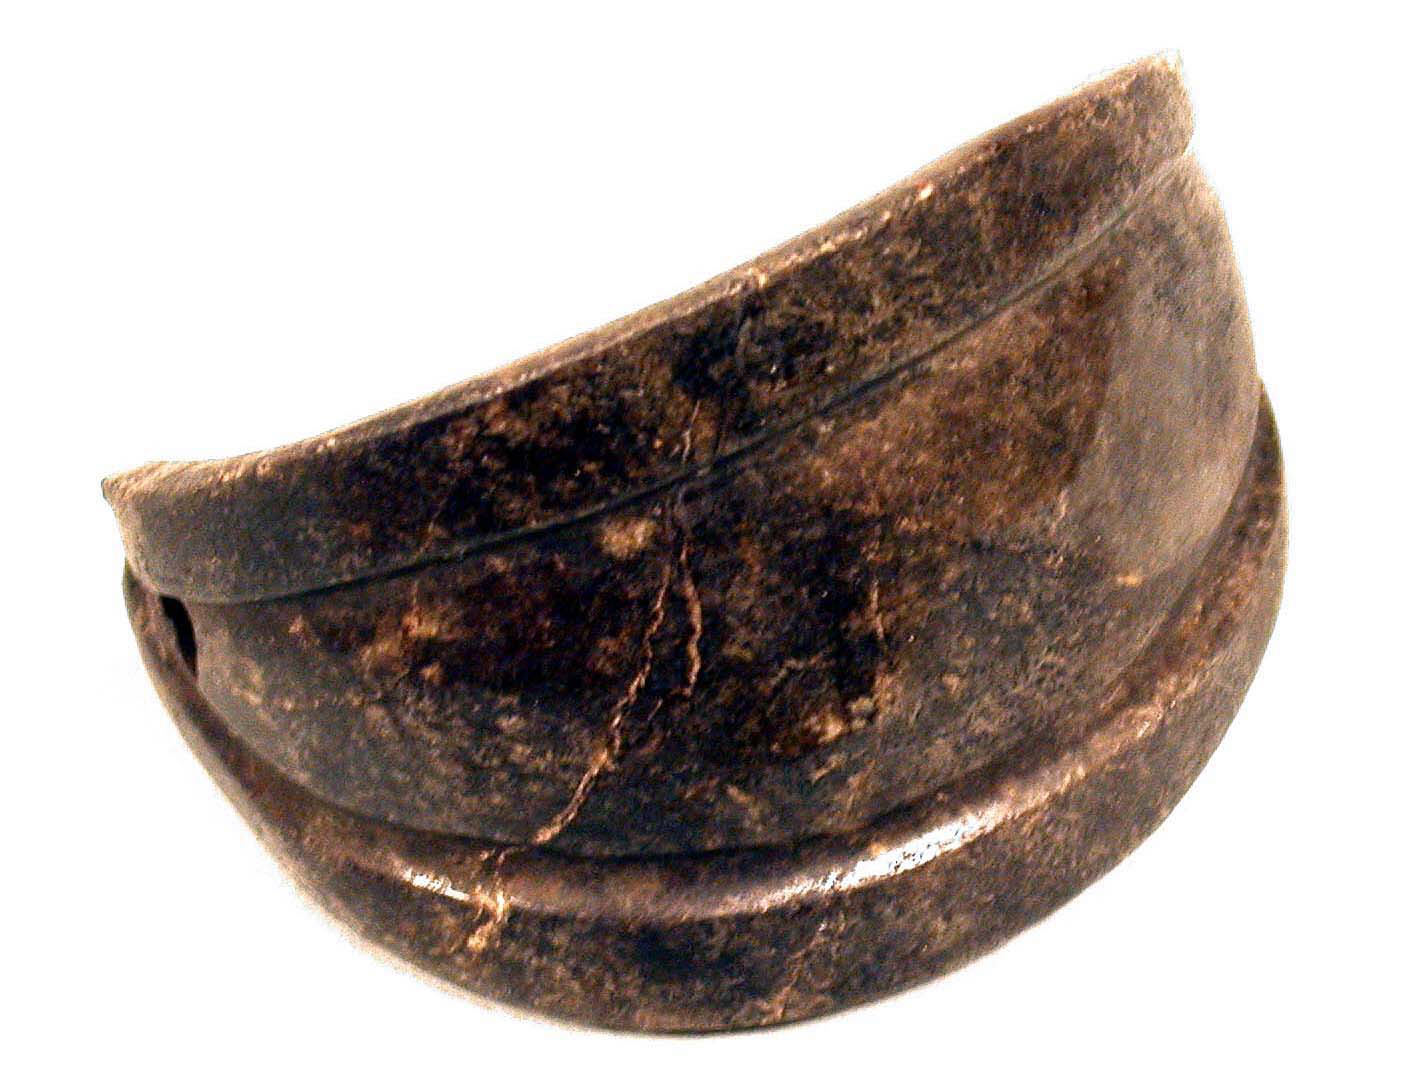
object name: finger grip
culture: mexican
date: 1501-1600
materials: stone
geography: mexico